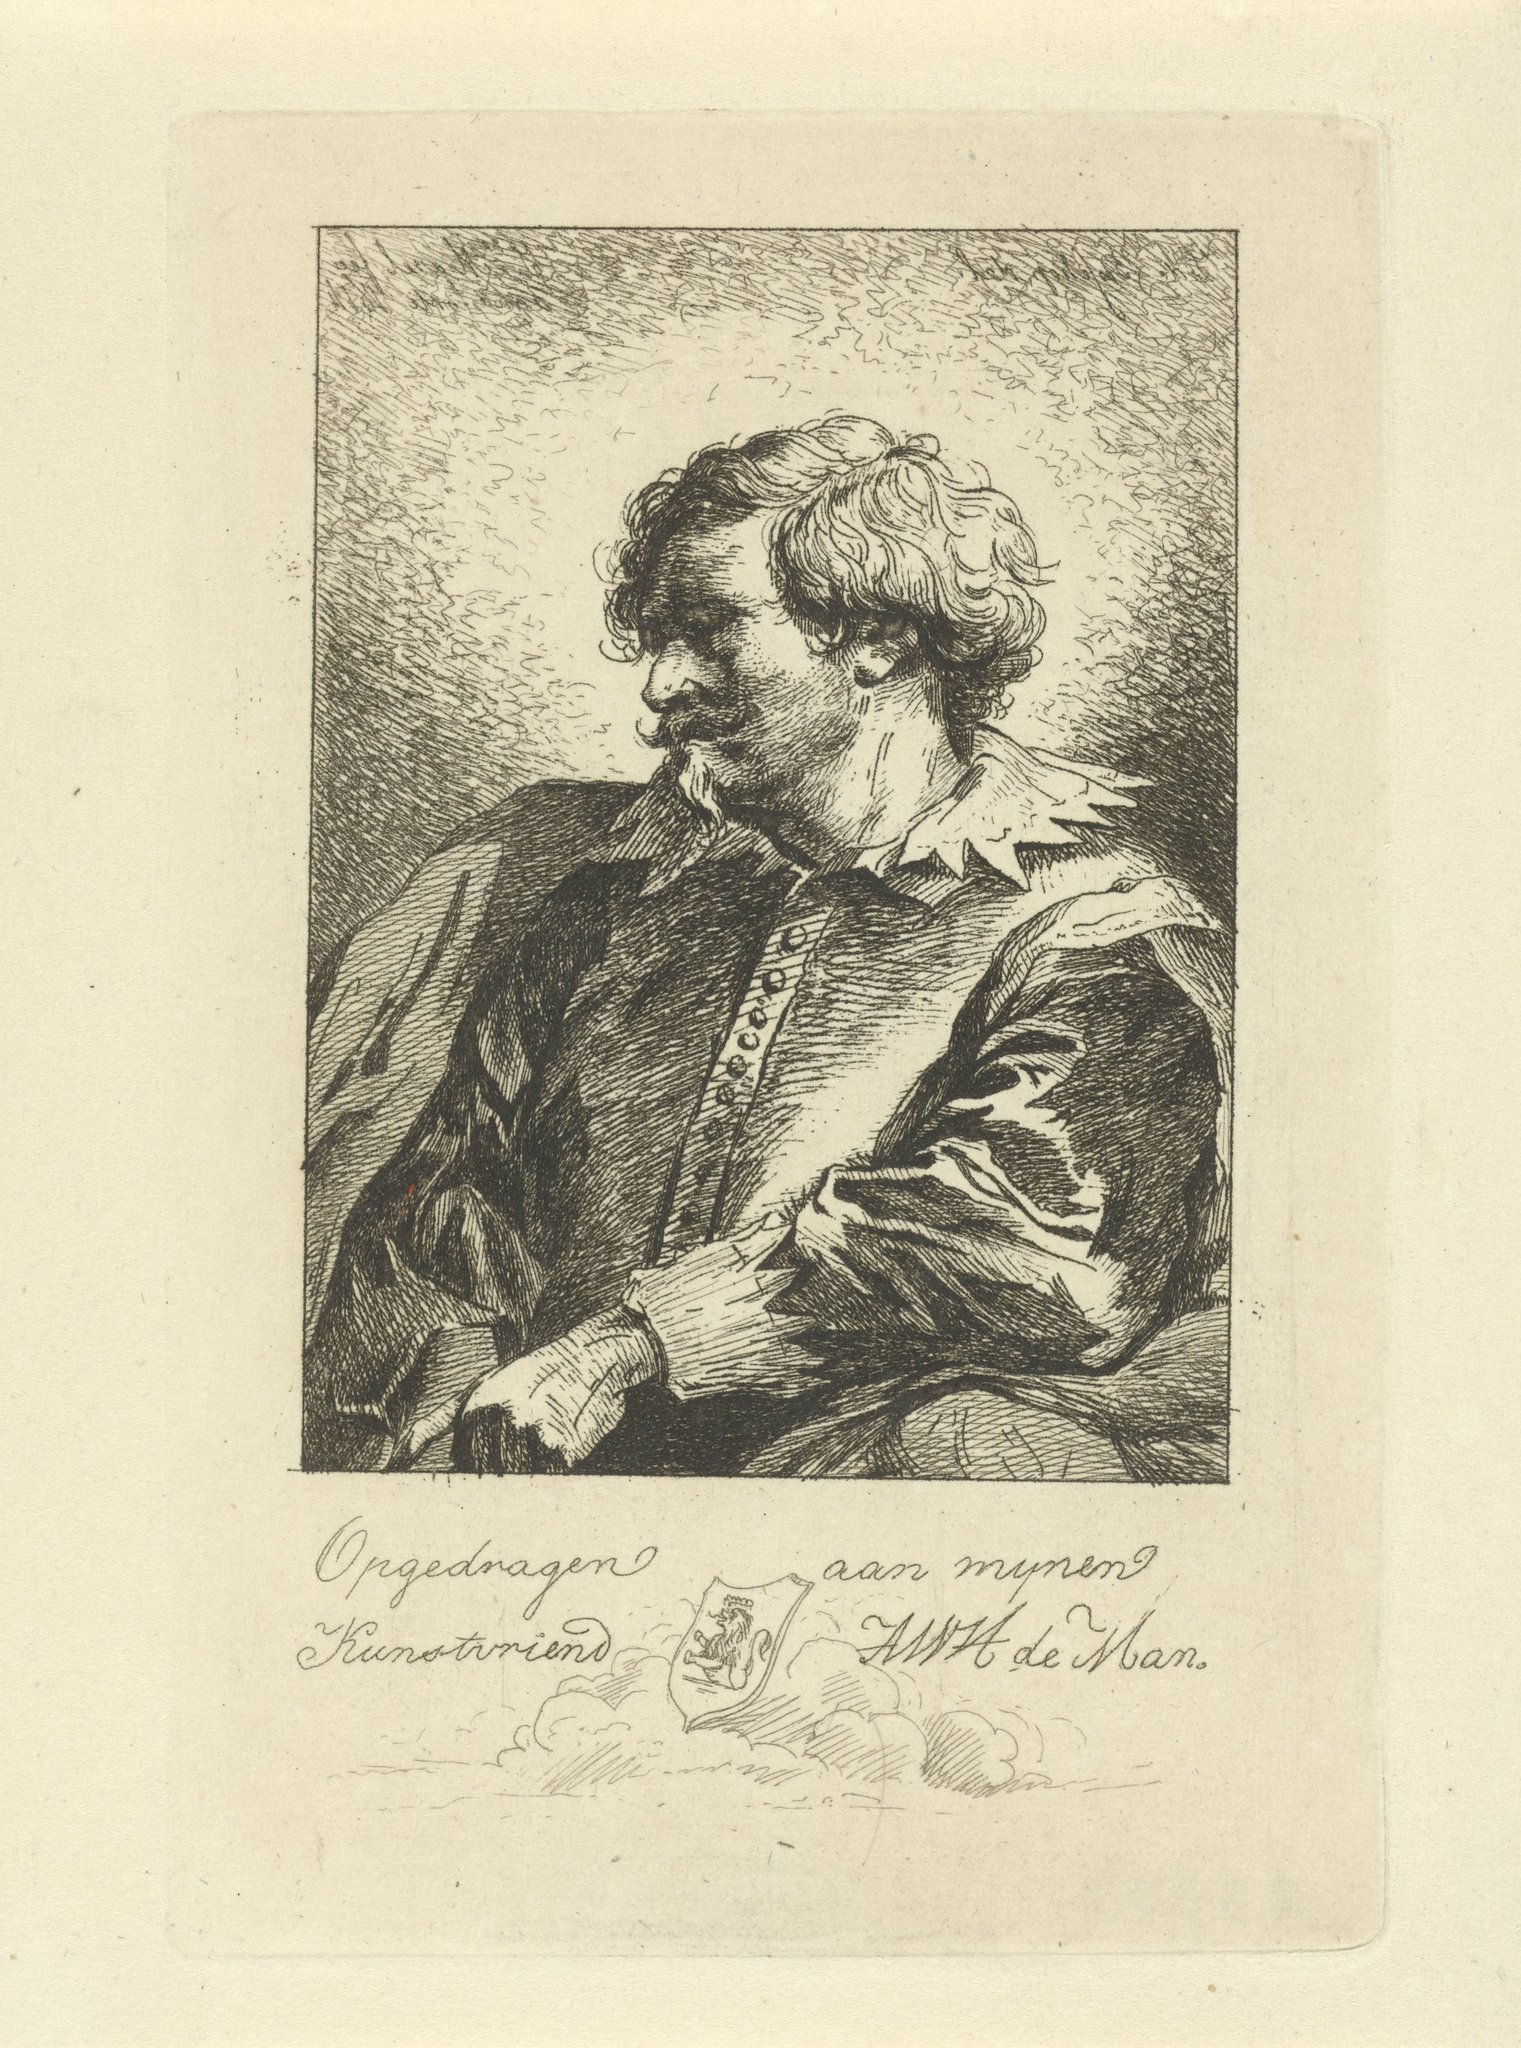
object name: print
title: Portret van een man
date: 1802-1882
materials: paper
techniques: etching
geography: netherlands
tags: adult man, armorial bearing, heraldry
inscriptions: collector's mark: Lugt 2228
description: Portret van een man in een kostuum met kraag. Onderaan in de marge de opdracht met een wapenschild, met een leeuw, op de wolken.